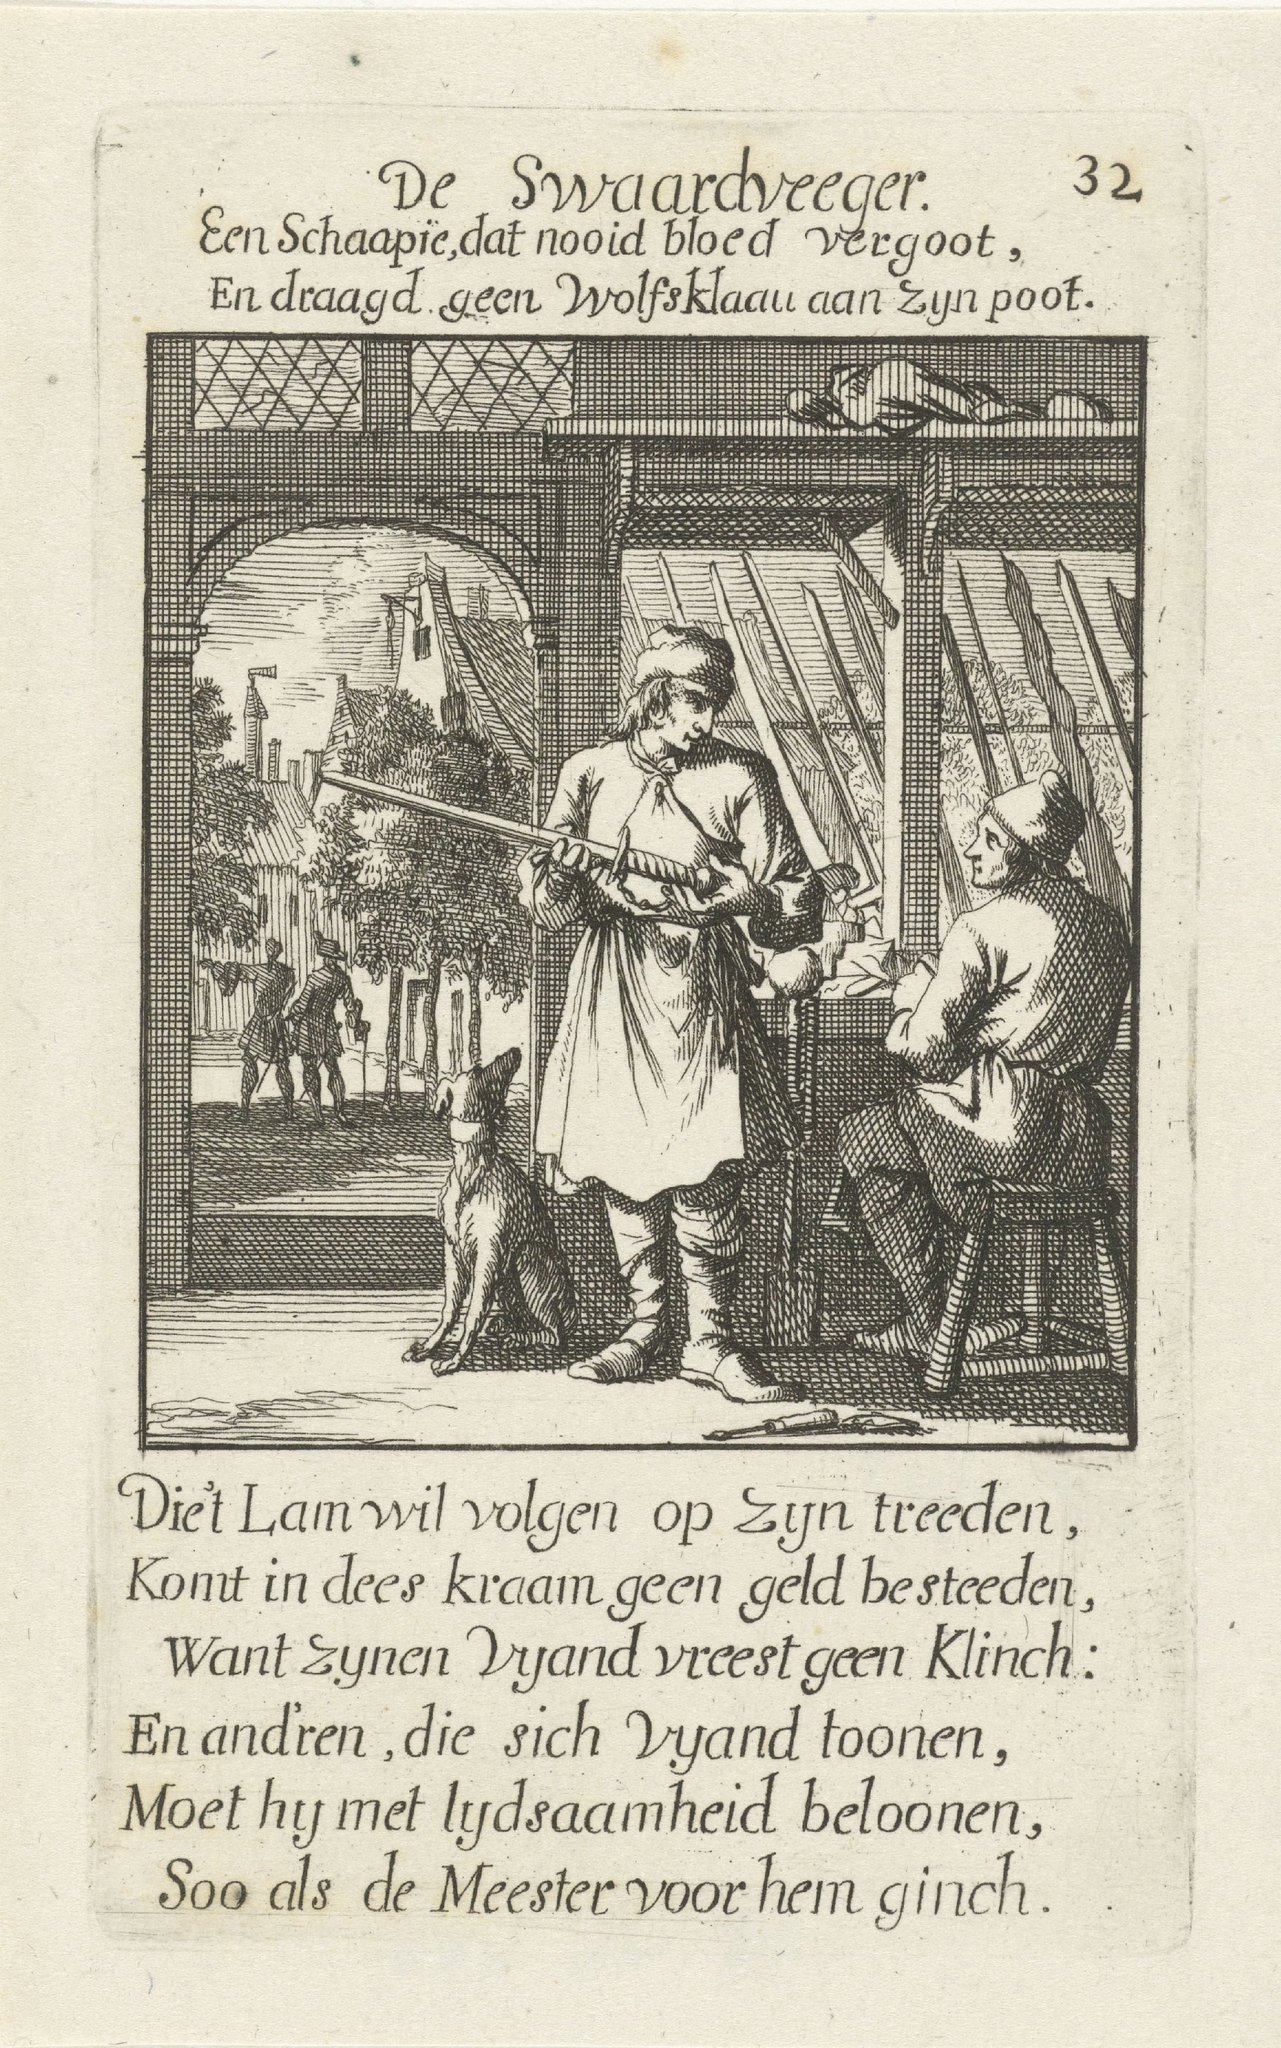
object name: print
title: Het Menselyk Bedryf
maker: jan luyken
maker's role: draughtsman, print maker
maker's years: 1649-1712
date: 1694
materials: paper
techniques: etching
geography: amsterdam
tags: handicrafts, craftsman at work, gun-smith, rifle-maker, armourer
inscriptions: collector's mark: Lugt 2228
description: Maakt deel uit van de 100-delige serie beroepsprenten van Jan en Caspar Luyken, getiteld: Het menselyk bedryf. S.l.s.n., 1694 (eerste druk).